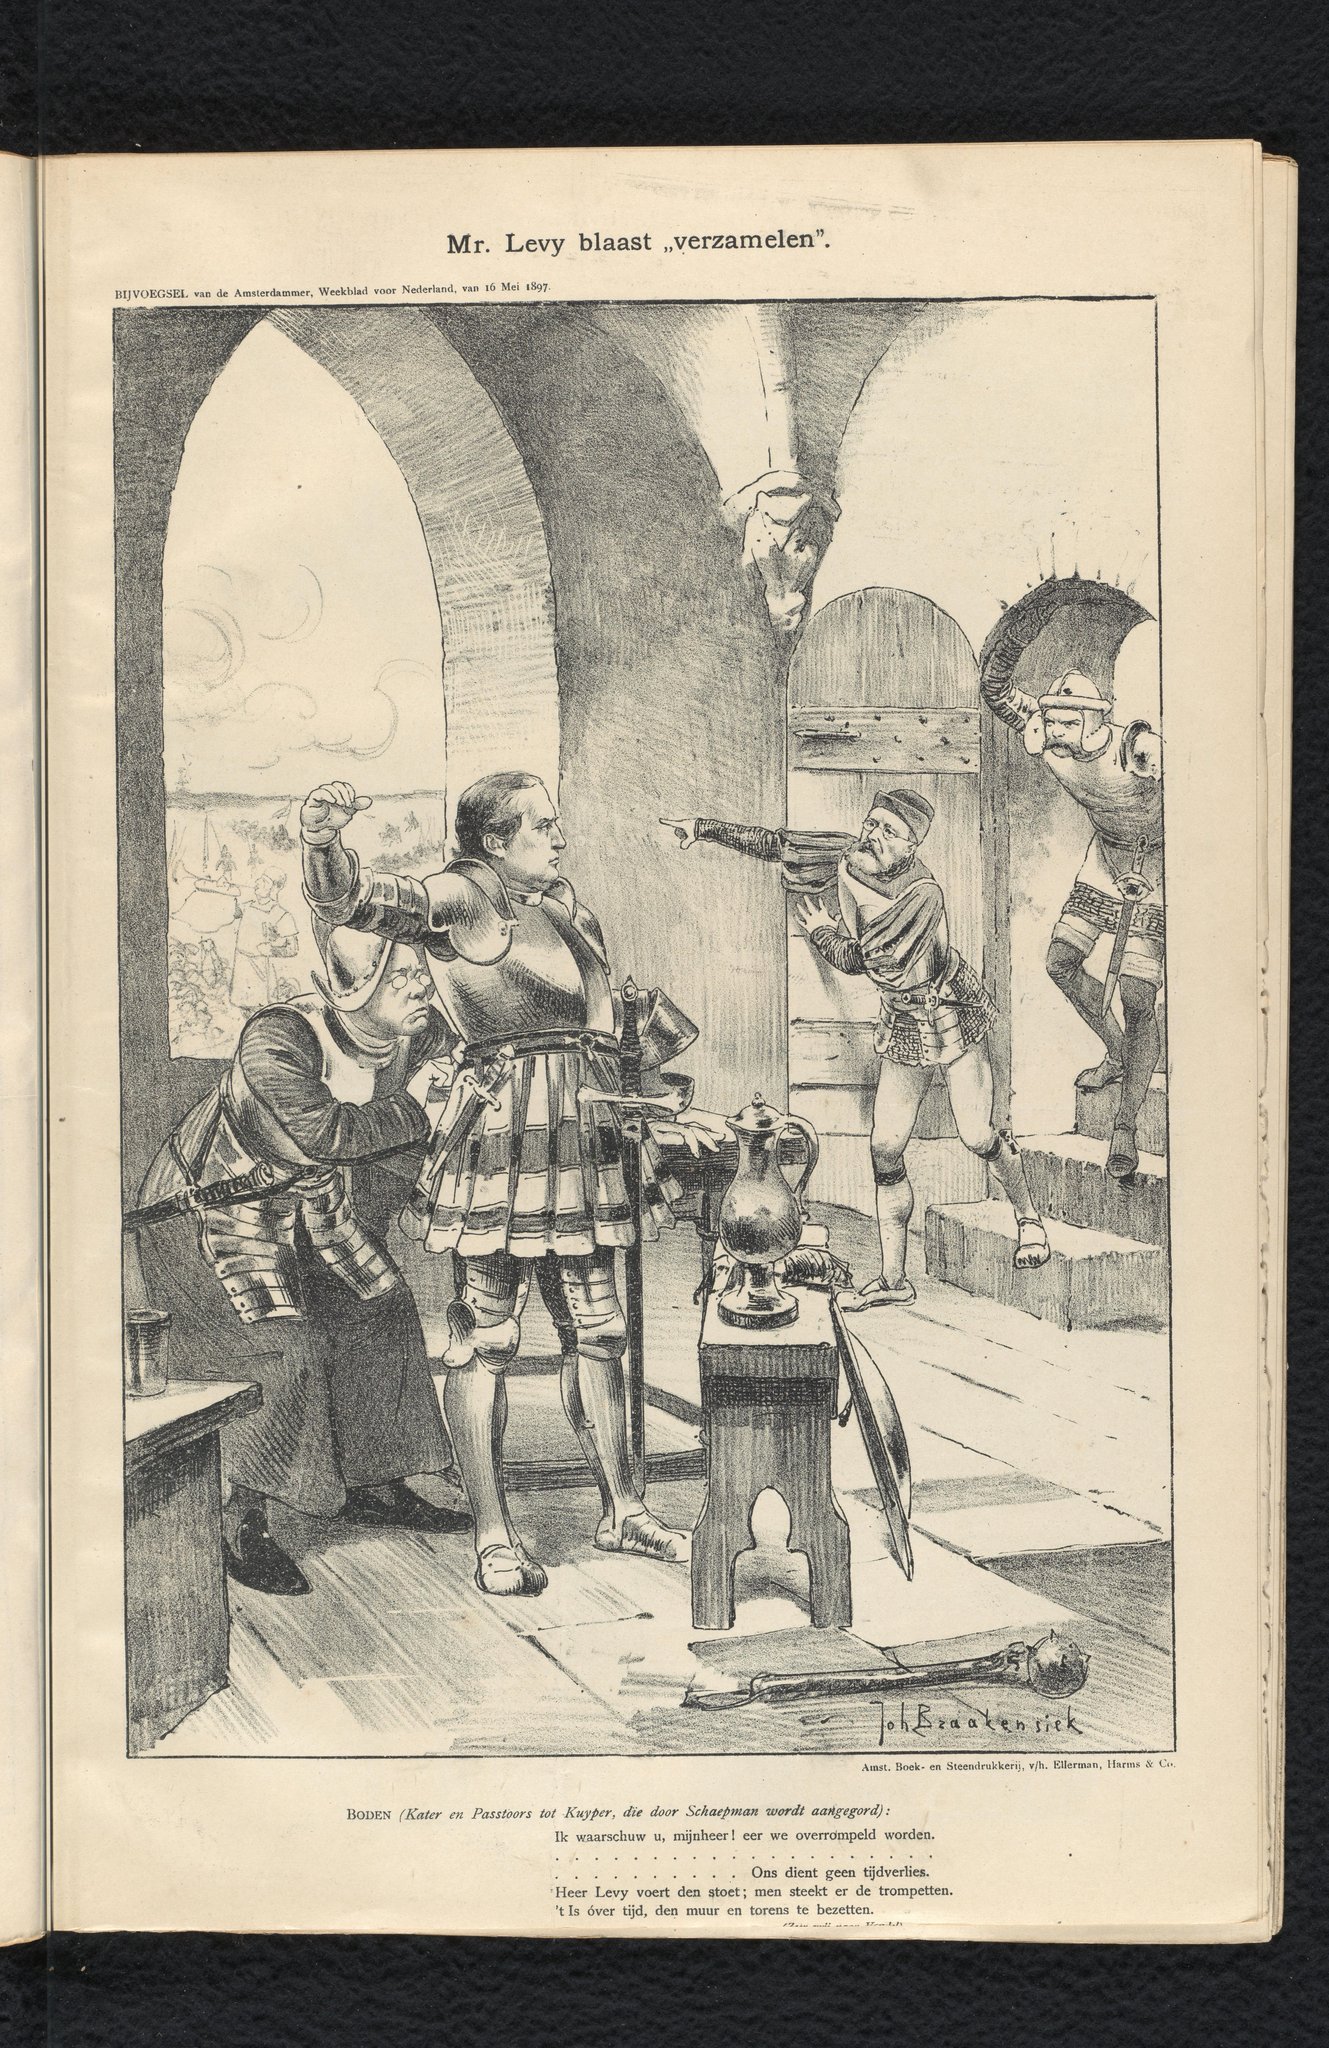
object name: cartoon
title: Mr. Levy blaast "verzamelen"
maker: johan braakensiek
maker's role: draughtsman, print maker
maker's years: 1858-1940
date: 1897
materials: paper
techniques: lithograph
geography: amsterdam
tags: the hague, abraham kuyper, rome, priest, herman johannes aloysius maria schaepman, amsterdam, armour, political caricatures and satires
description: Abraham Kuyper wordt door dr. Schaepman in het harnas geholpen. De boden Klaas Kater en Willem Passtoors komen waarschuwen dat de troepen onder aanvoering van Levy zich voorbereiden op de aanval.